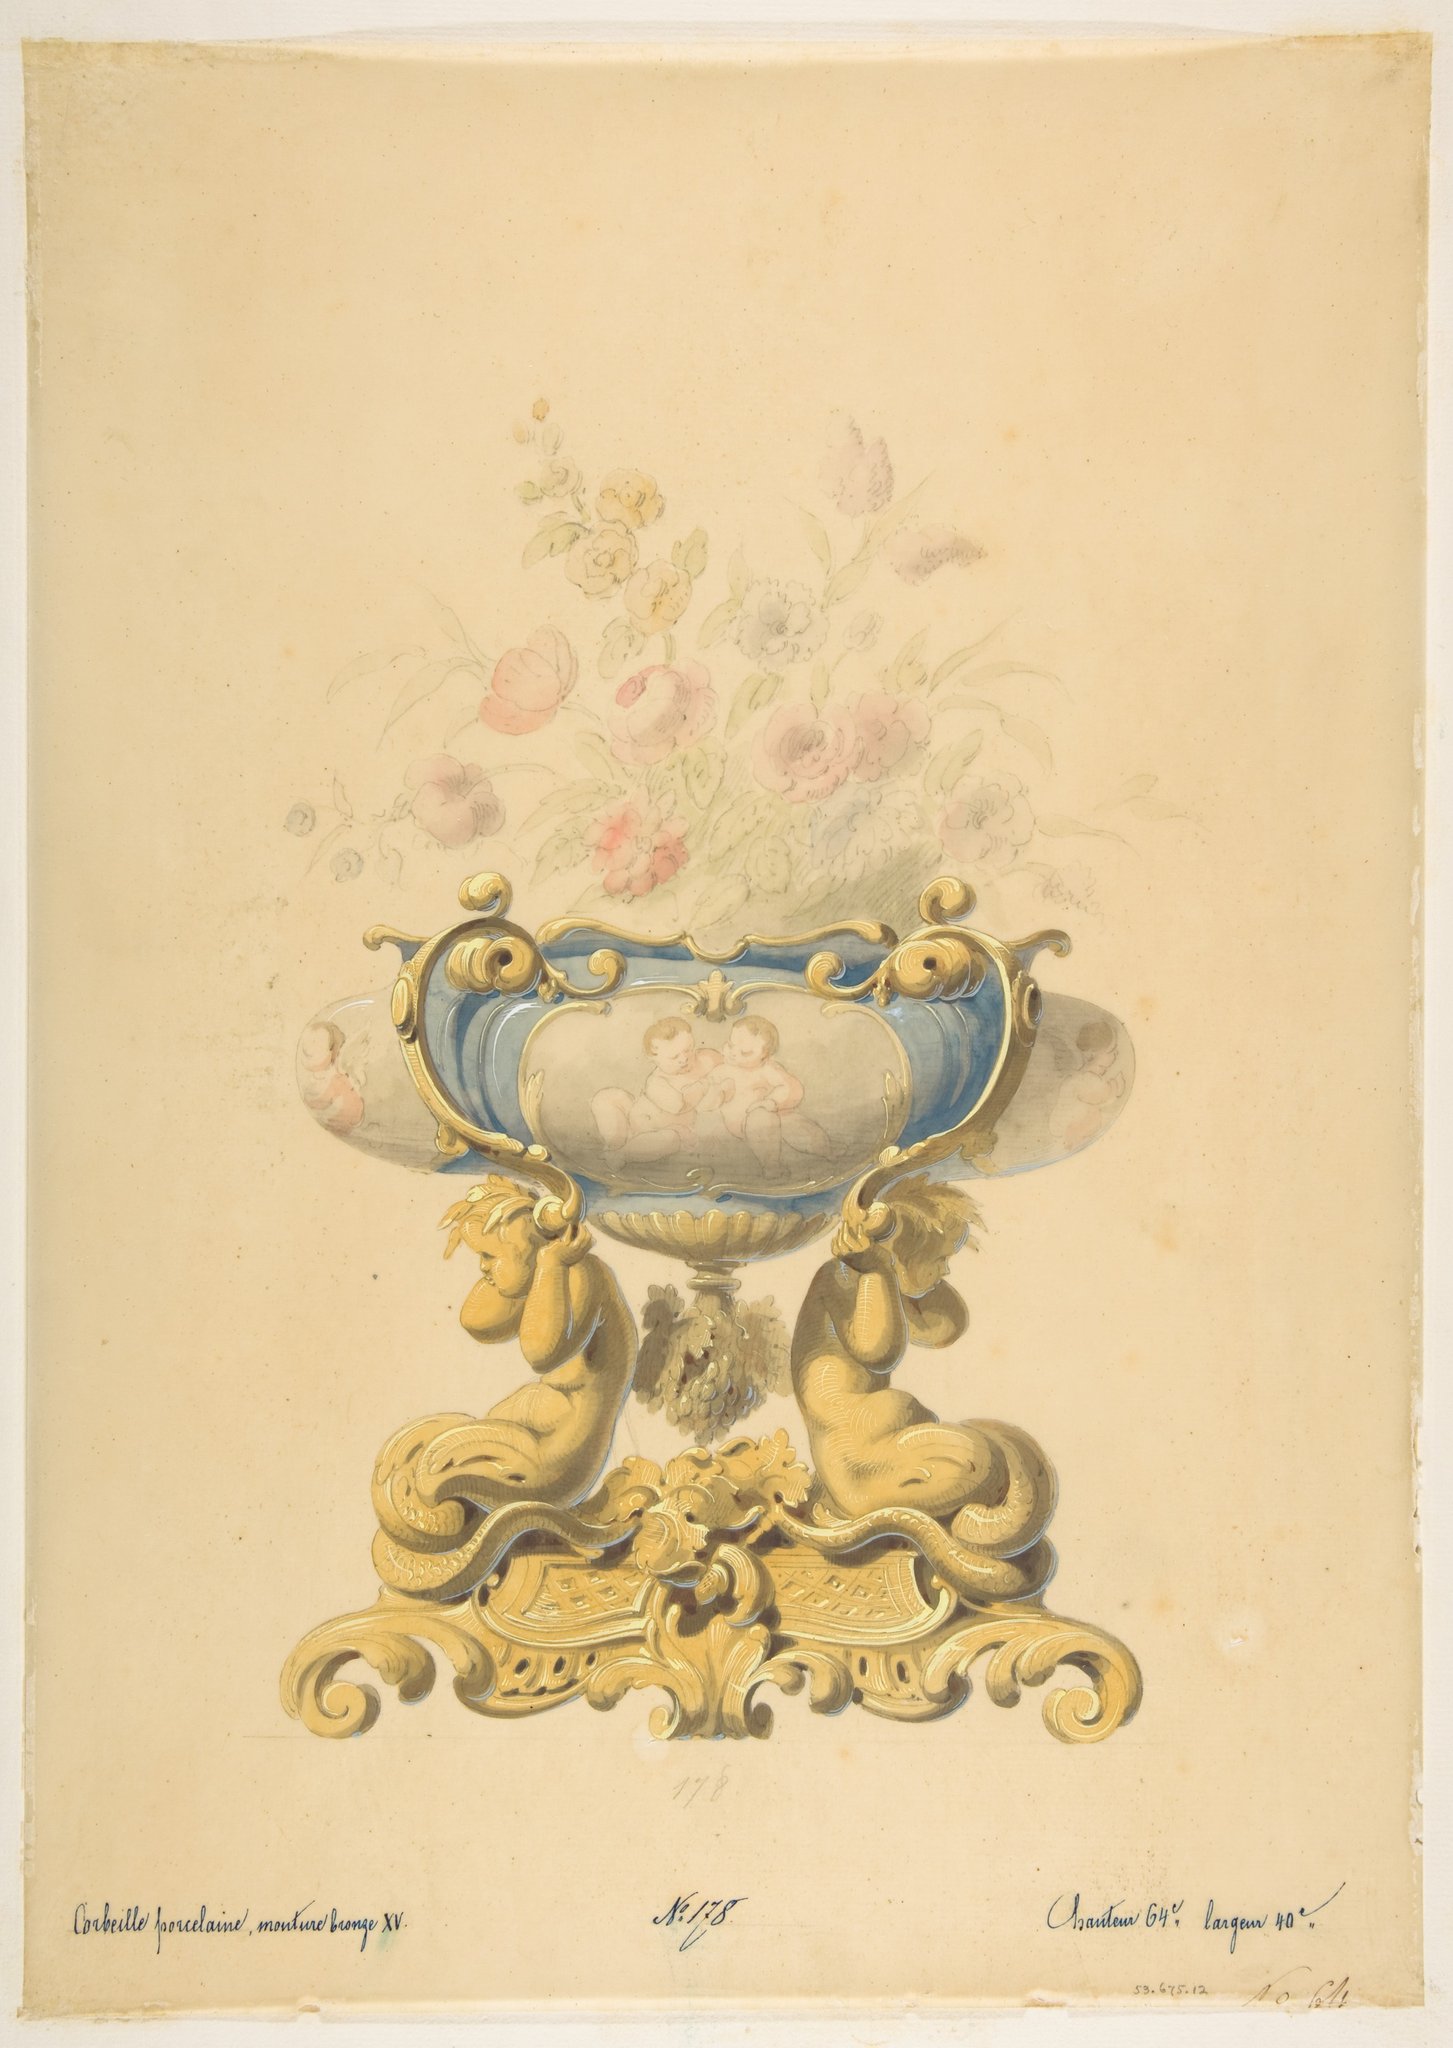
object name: drawing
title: Design for a Porcelain Flower Bowl with Bronze Mount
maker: anonymous, french, 19th century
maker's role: artist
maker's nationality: french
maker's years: 1800-1900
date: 1801-1900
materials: gouache, graphite, watercolor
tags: infants,flowers,bowls